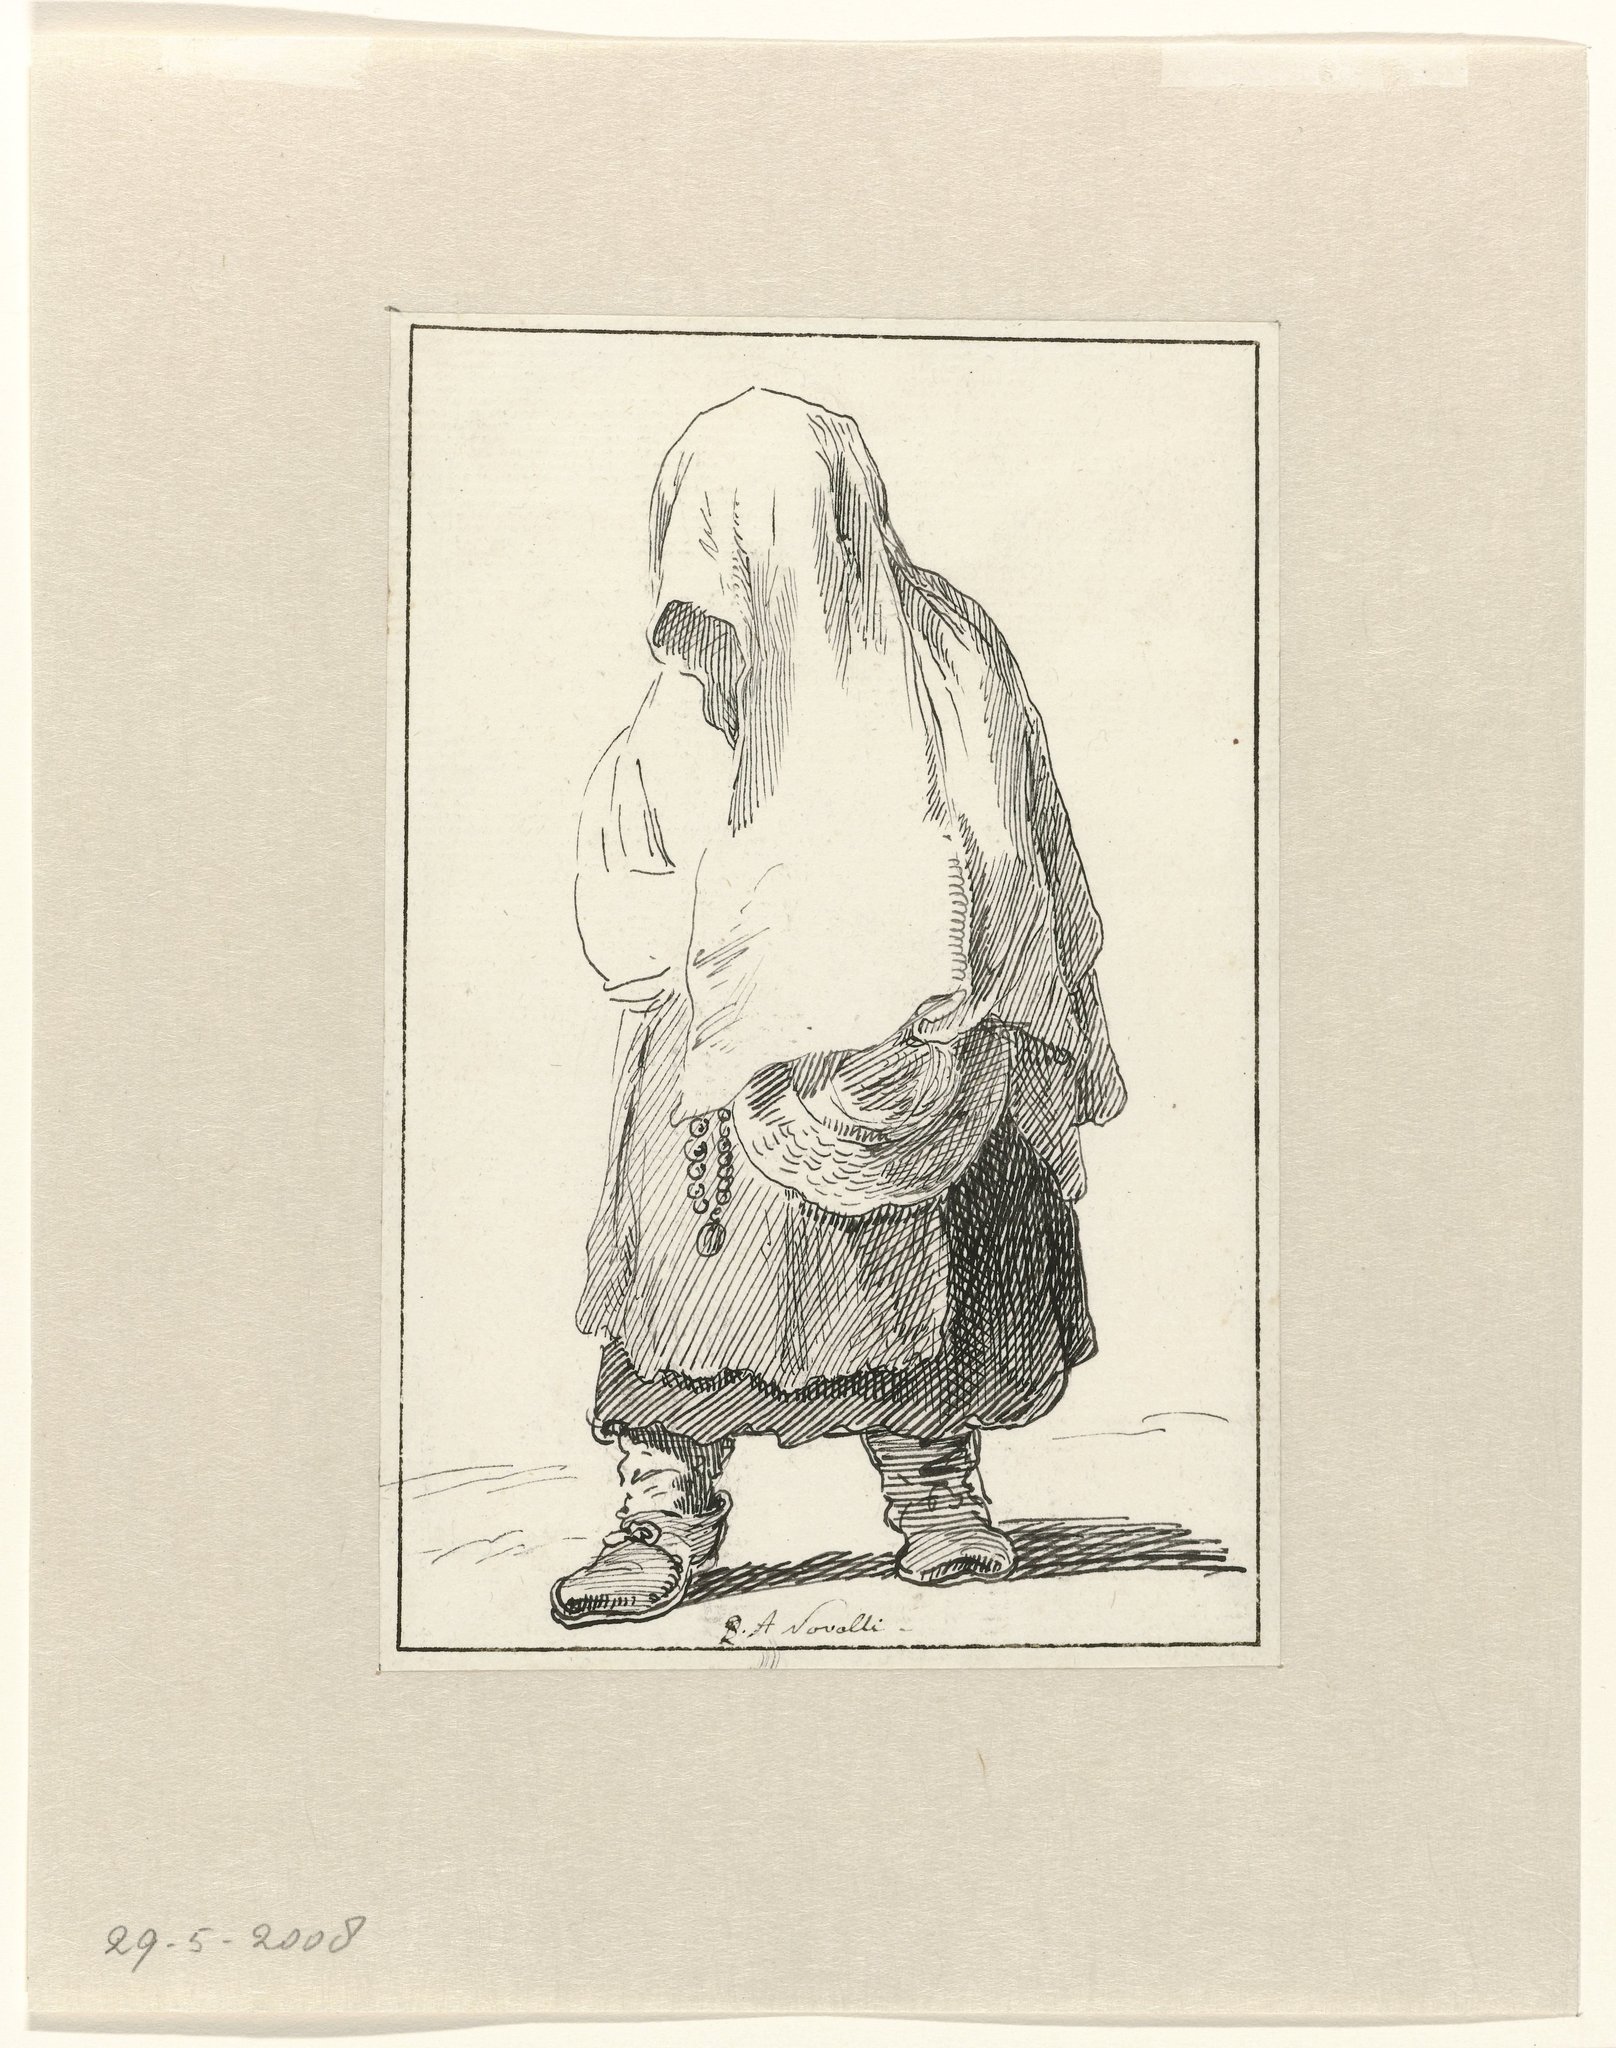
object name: drawing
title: Een gesluierde vrouw met een rozenkrans in haar hand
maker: pietro antonio iii novelli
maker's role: draughtsman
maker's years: 1729-1804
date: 1739-1804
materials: ink, paper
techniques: pen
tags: koning, philippus ii van macedonië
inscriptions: signature: ‘P.A. Novelli’